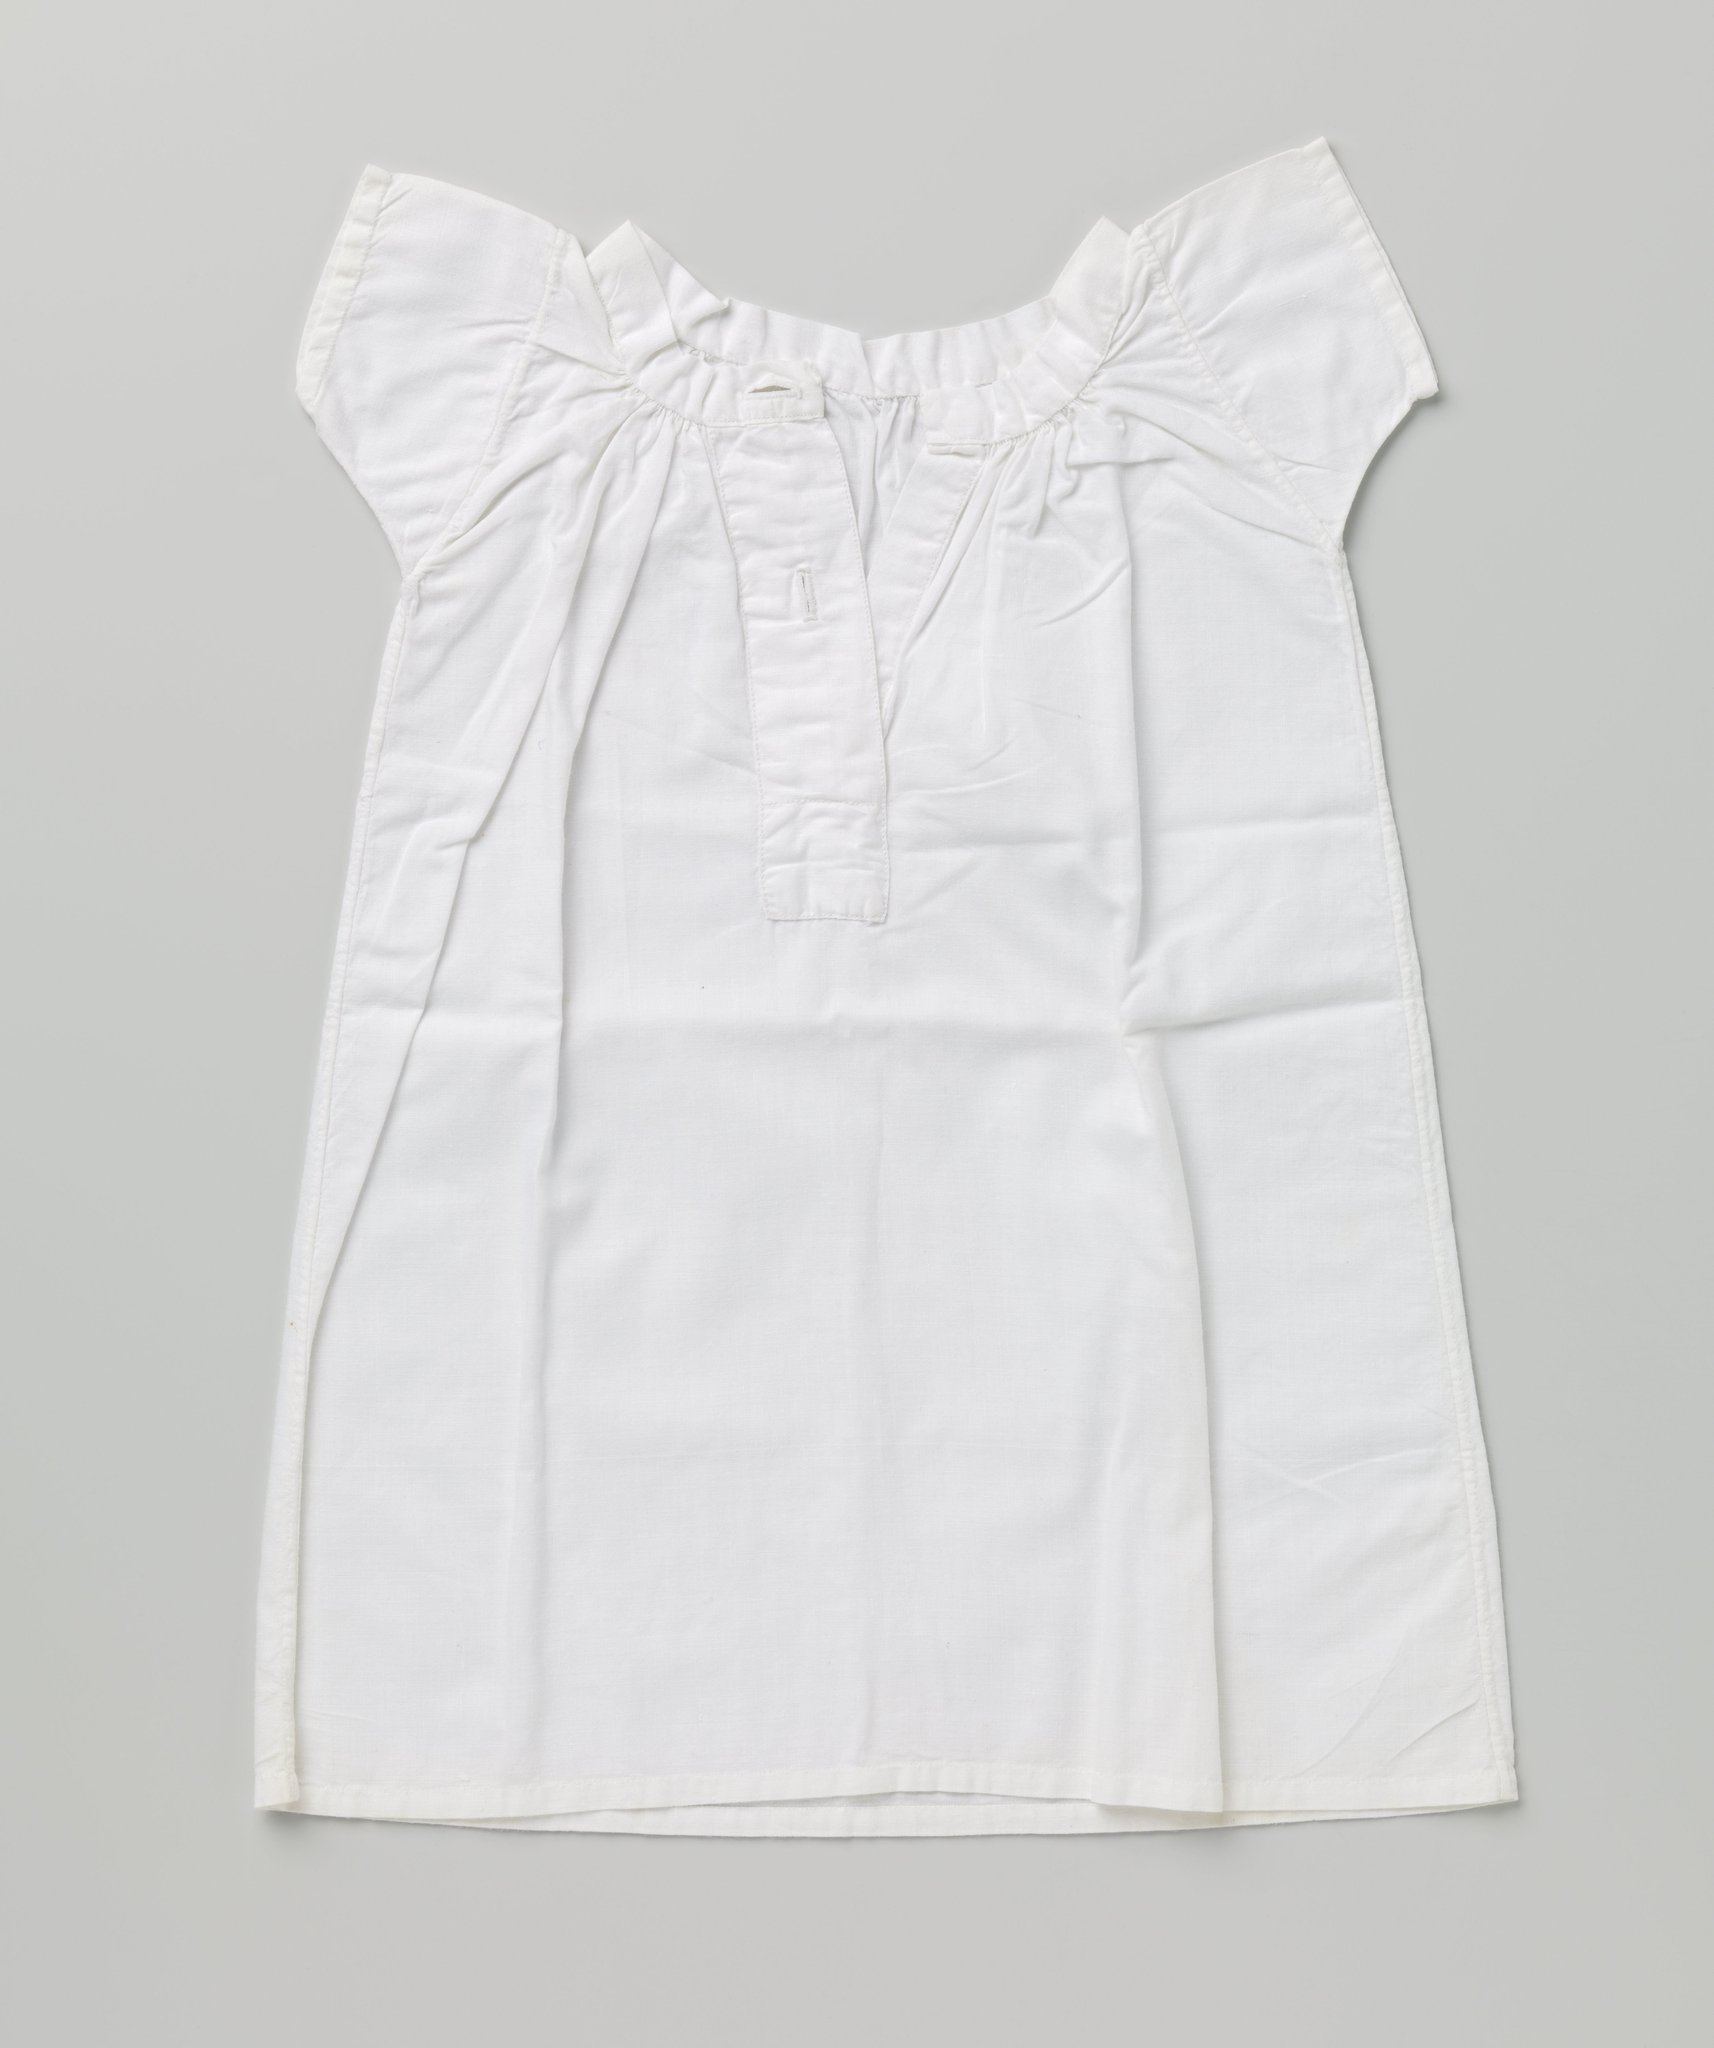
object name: menswear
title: Hemd met halve mouw, handwerk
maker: g. glas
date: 1888-1894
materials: linen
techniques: sewing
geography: deventer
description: Een linnen manshemd met halve mouw. Kleinmodel ondergoed. Handwerk vervaardigd op de Normaalschool te Deventer voor de akte `Nuttige handwerken'.